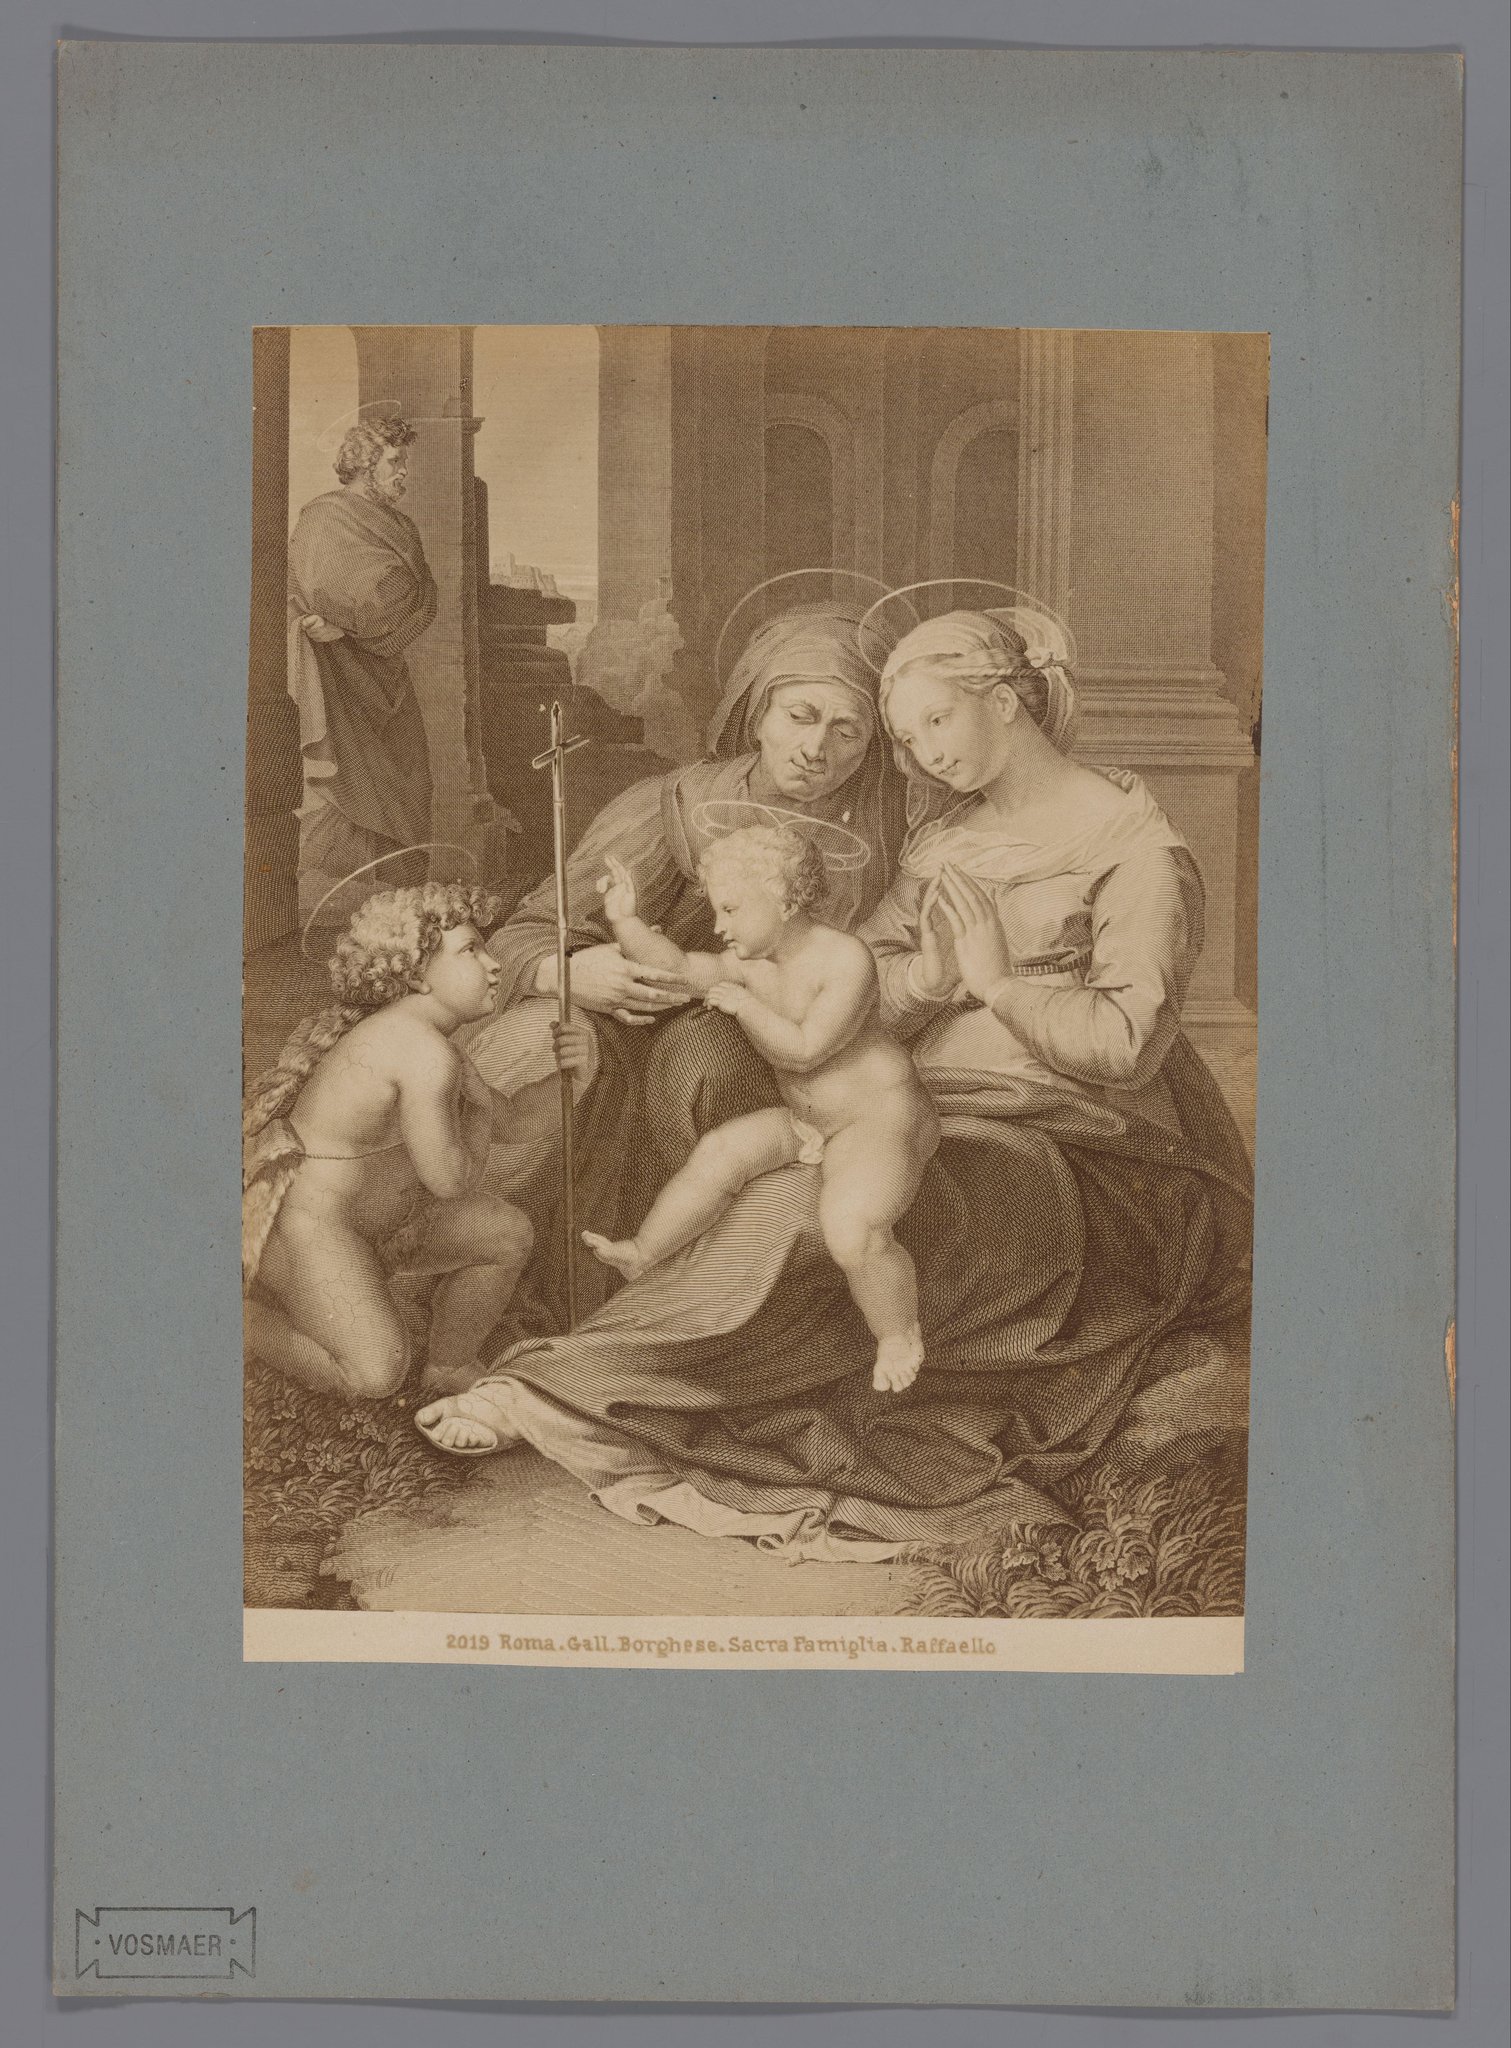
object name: reproduction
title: Roma. Gall. Borghese. Sacra Famiglia. Raffaello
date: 1851-1900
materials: cardboard, paper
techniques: albumen print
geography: rome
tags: drawing, sketch, picture, painting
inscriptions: collector's mark: ‘VOSMAER’, number: ‘2019’